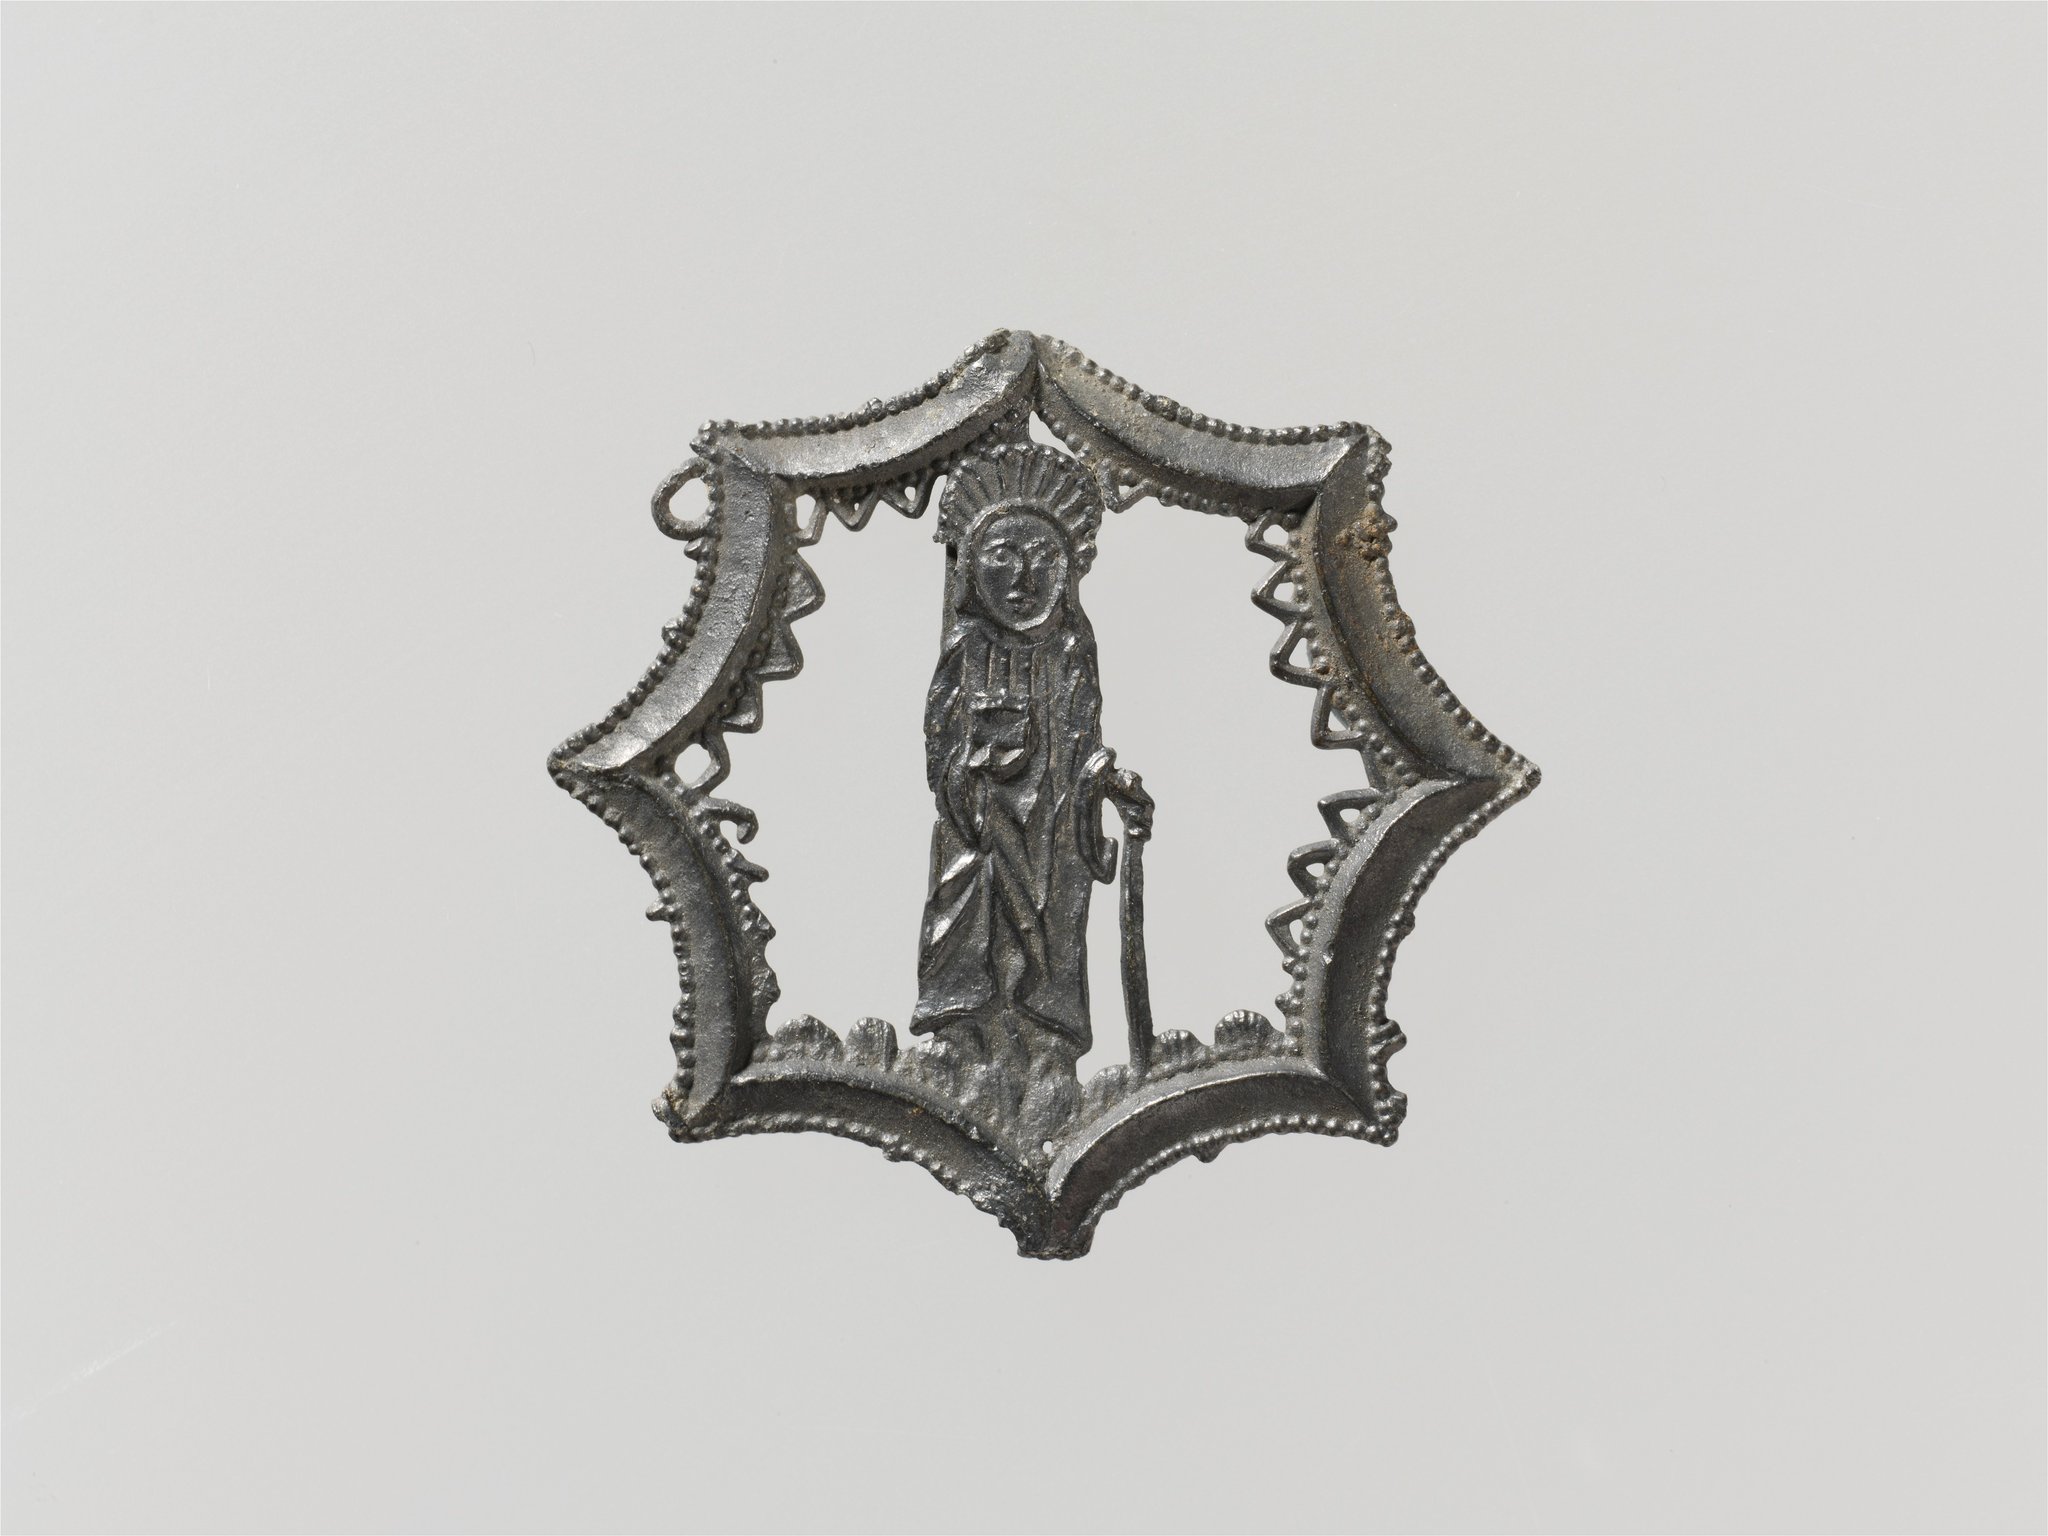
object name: pilgrim's badge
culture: french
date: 1401-1500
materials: lead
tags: saints